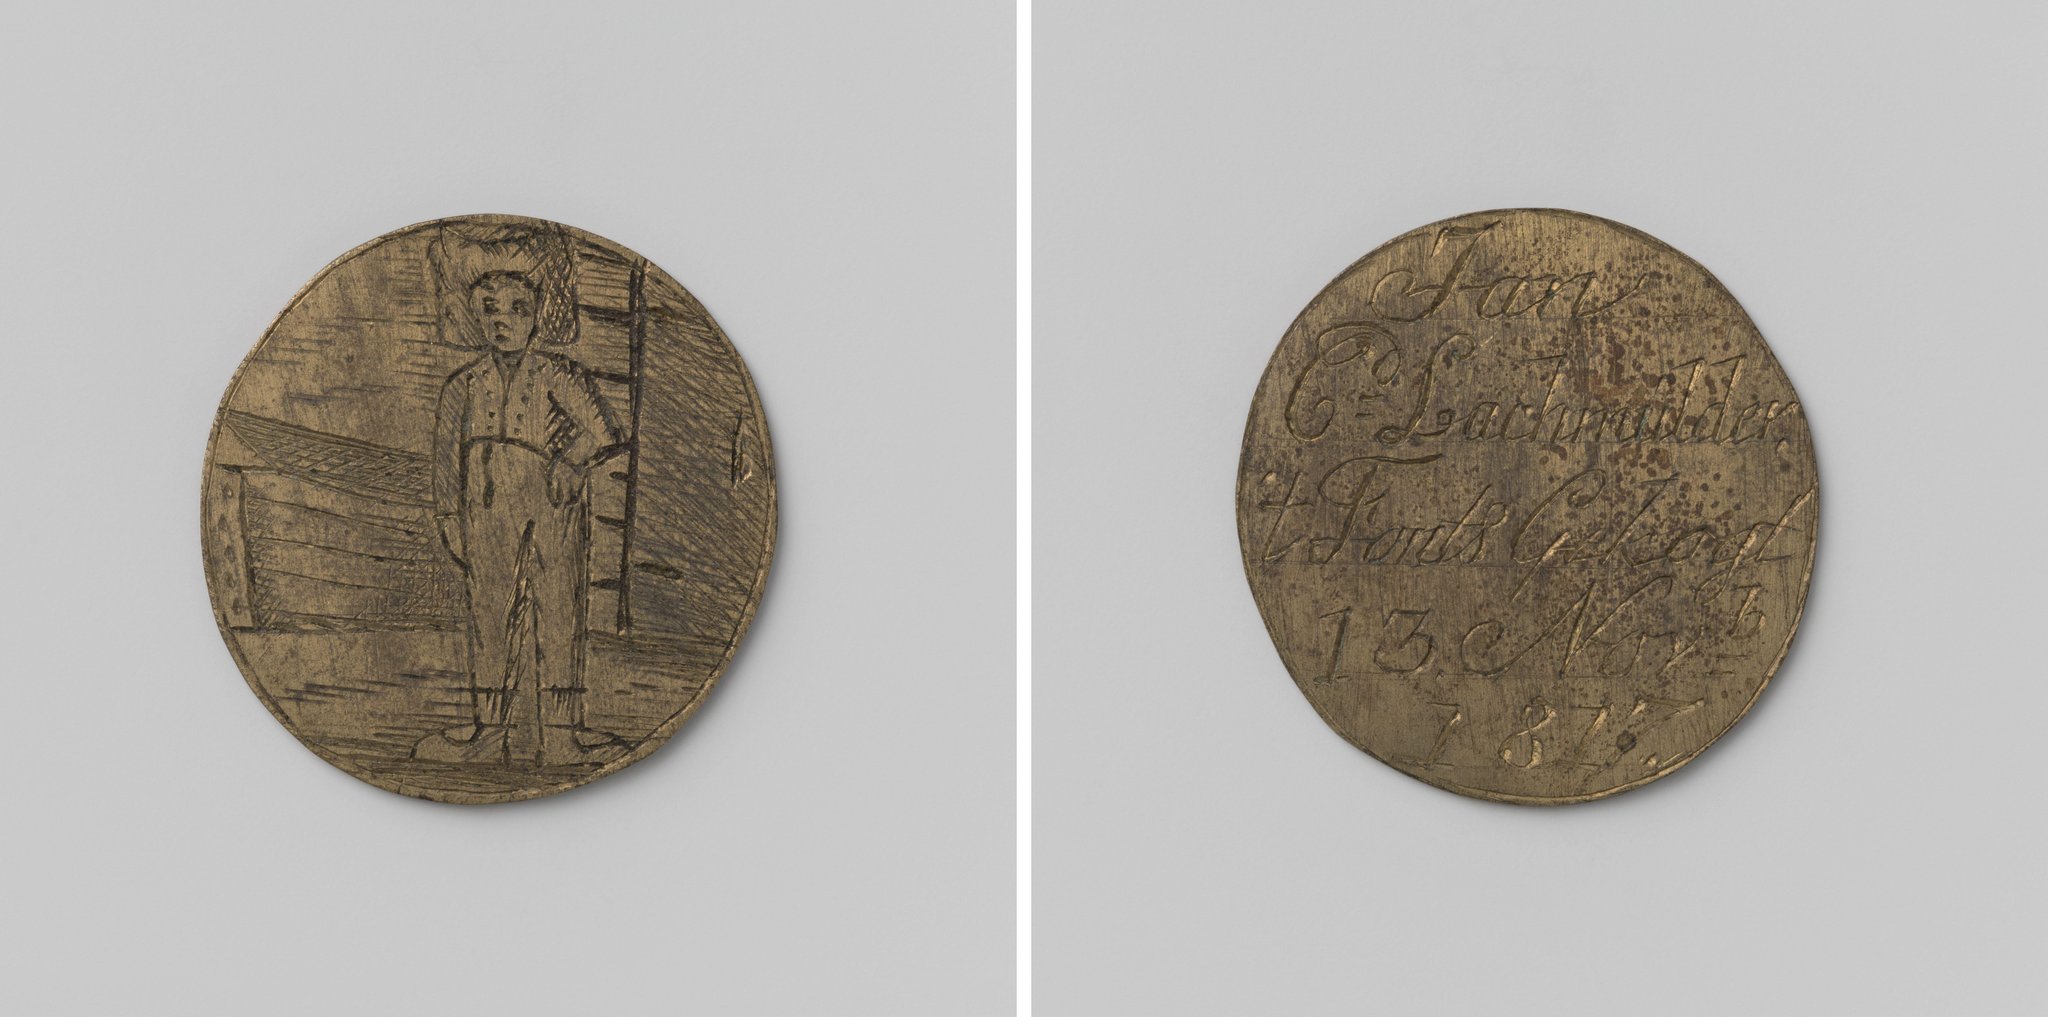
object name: medal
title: Korendragers- en -stortersgilde van Amsterdam, gildepenning van Jan C. Lachmulder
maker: Anonymous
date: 1817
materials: brass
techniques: engraving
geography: amsterdam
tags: amsterdam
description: Messing penning. Voorzijde: man met last op hoofd en face; op achtergrond: lichterschuit en poort. Keerzijde: opschrift